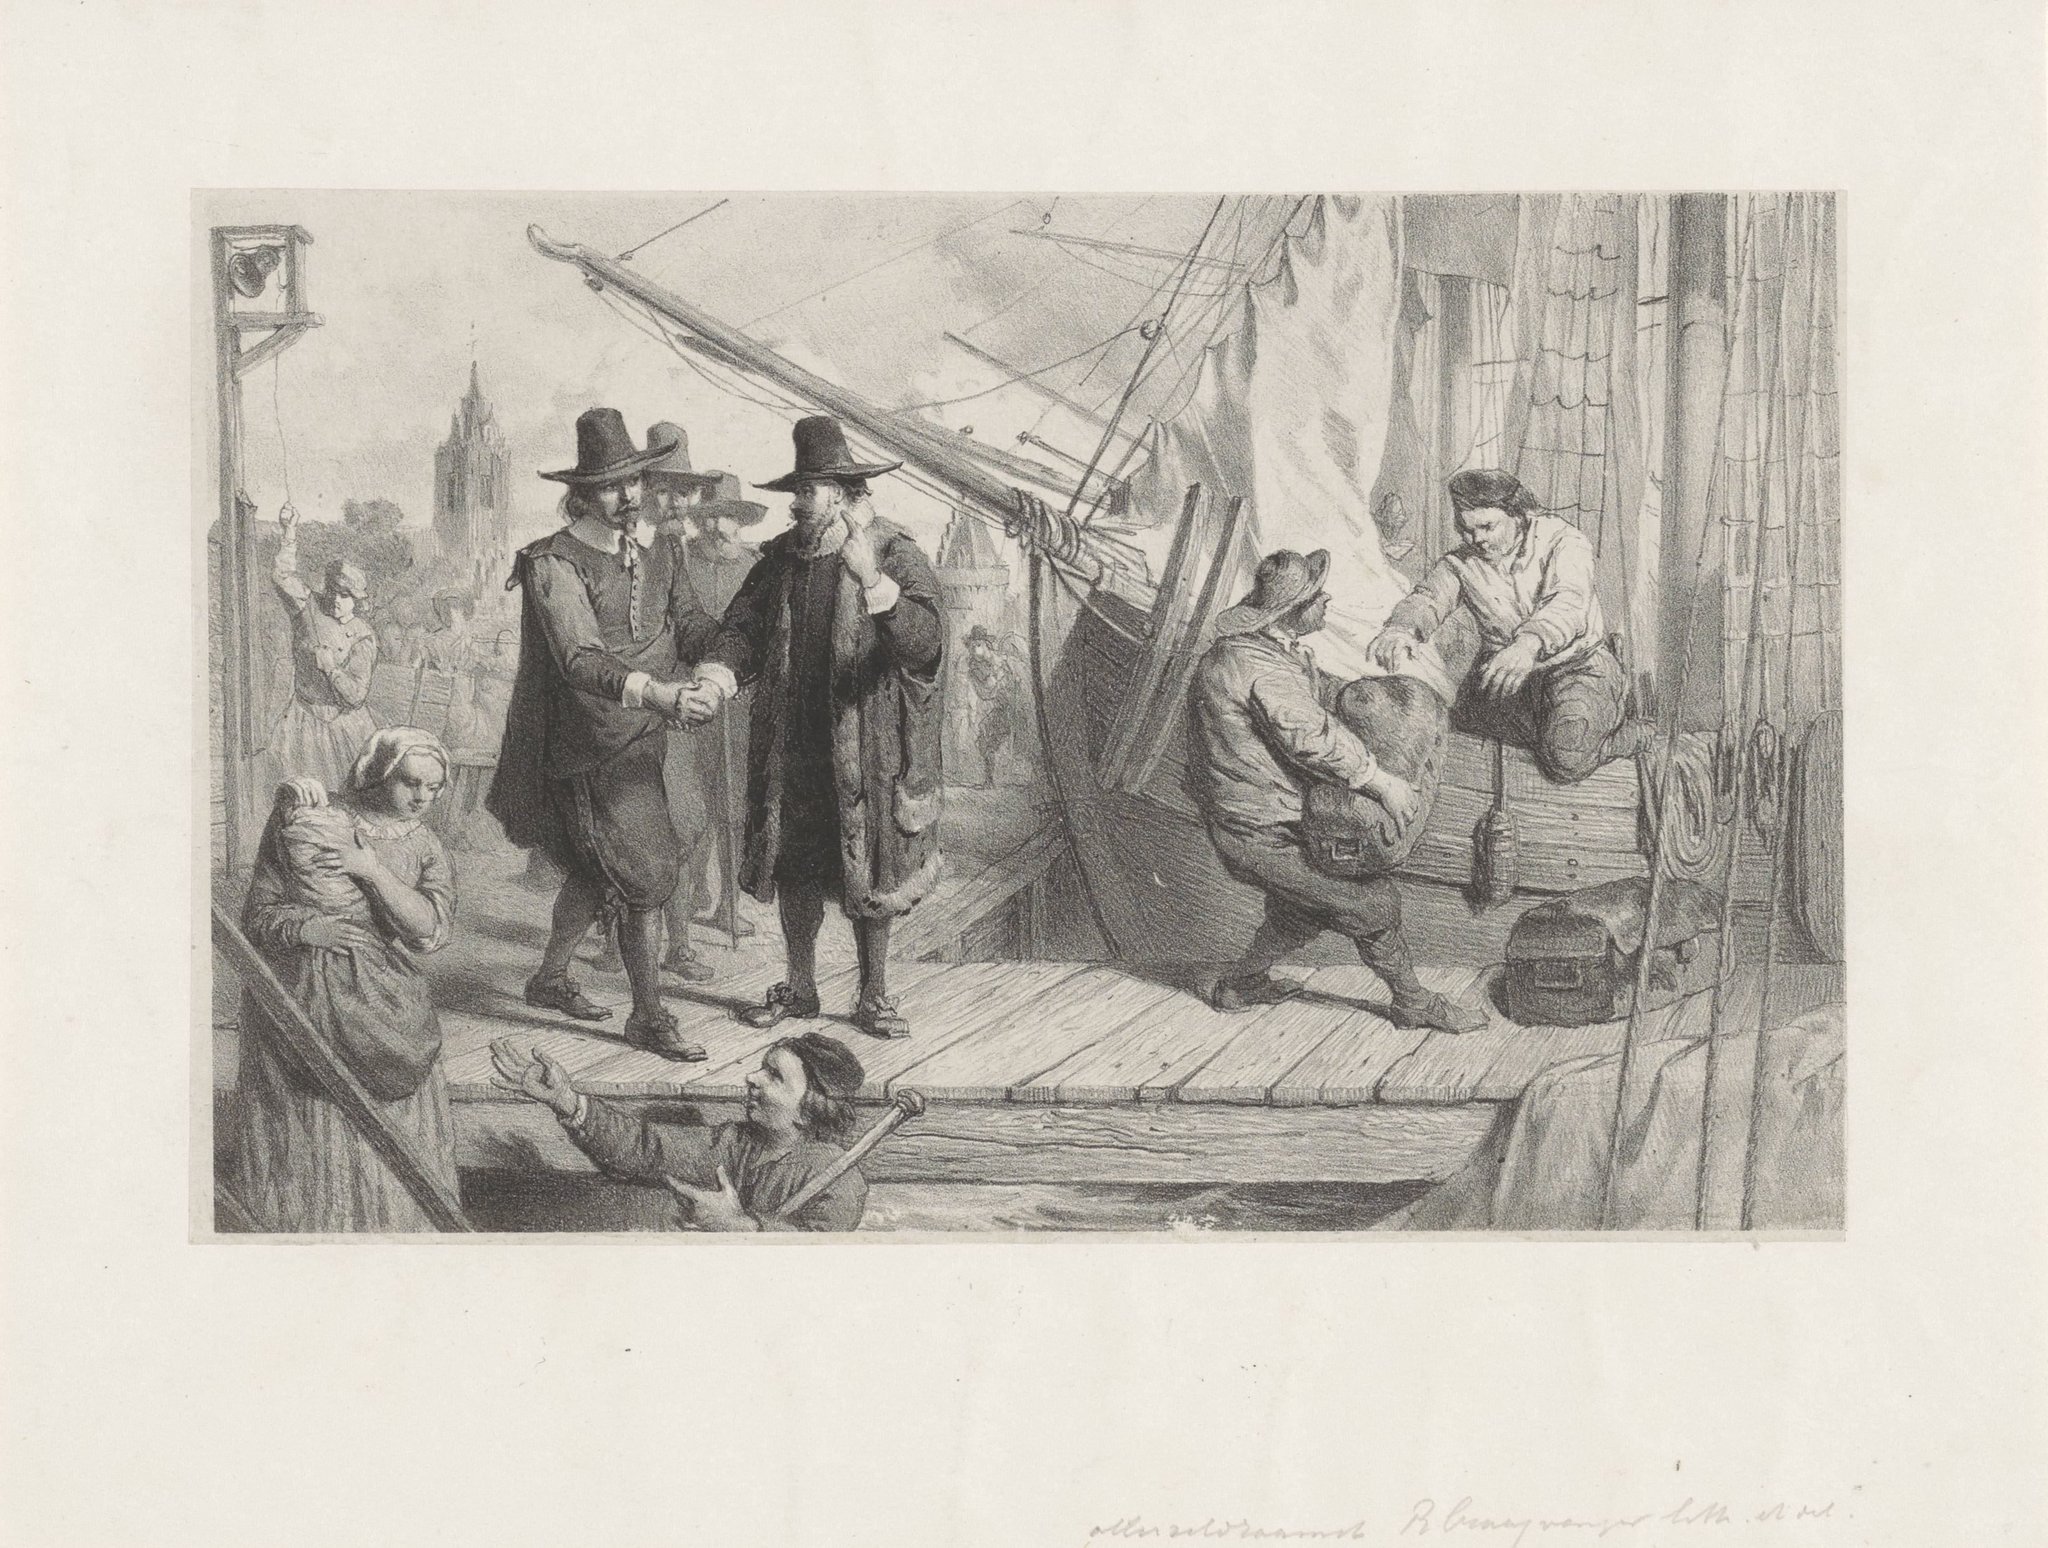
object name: print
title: Het laden van een schip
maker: reinier craeyvanger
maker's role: draughtsman, print maker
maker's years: 1812-1880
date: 1822-1880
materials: paper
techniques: lithograph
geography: netherlands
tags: shaking hands, 'dextrarum junctio', ships (in general) (+ loading), bell ~ acoustic signalling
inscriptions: inscription: ‘allerzeldzamst R. Craeyvanger lith et del’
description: Op een aanlegsteiger staat een groep mannen met hoeden. Twee van hen schudden elkaar de hand. Rechts van hen worden spullen in een schip geladen. Links van hen luidt een vrouw een klok.